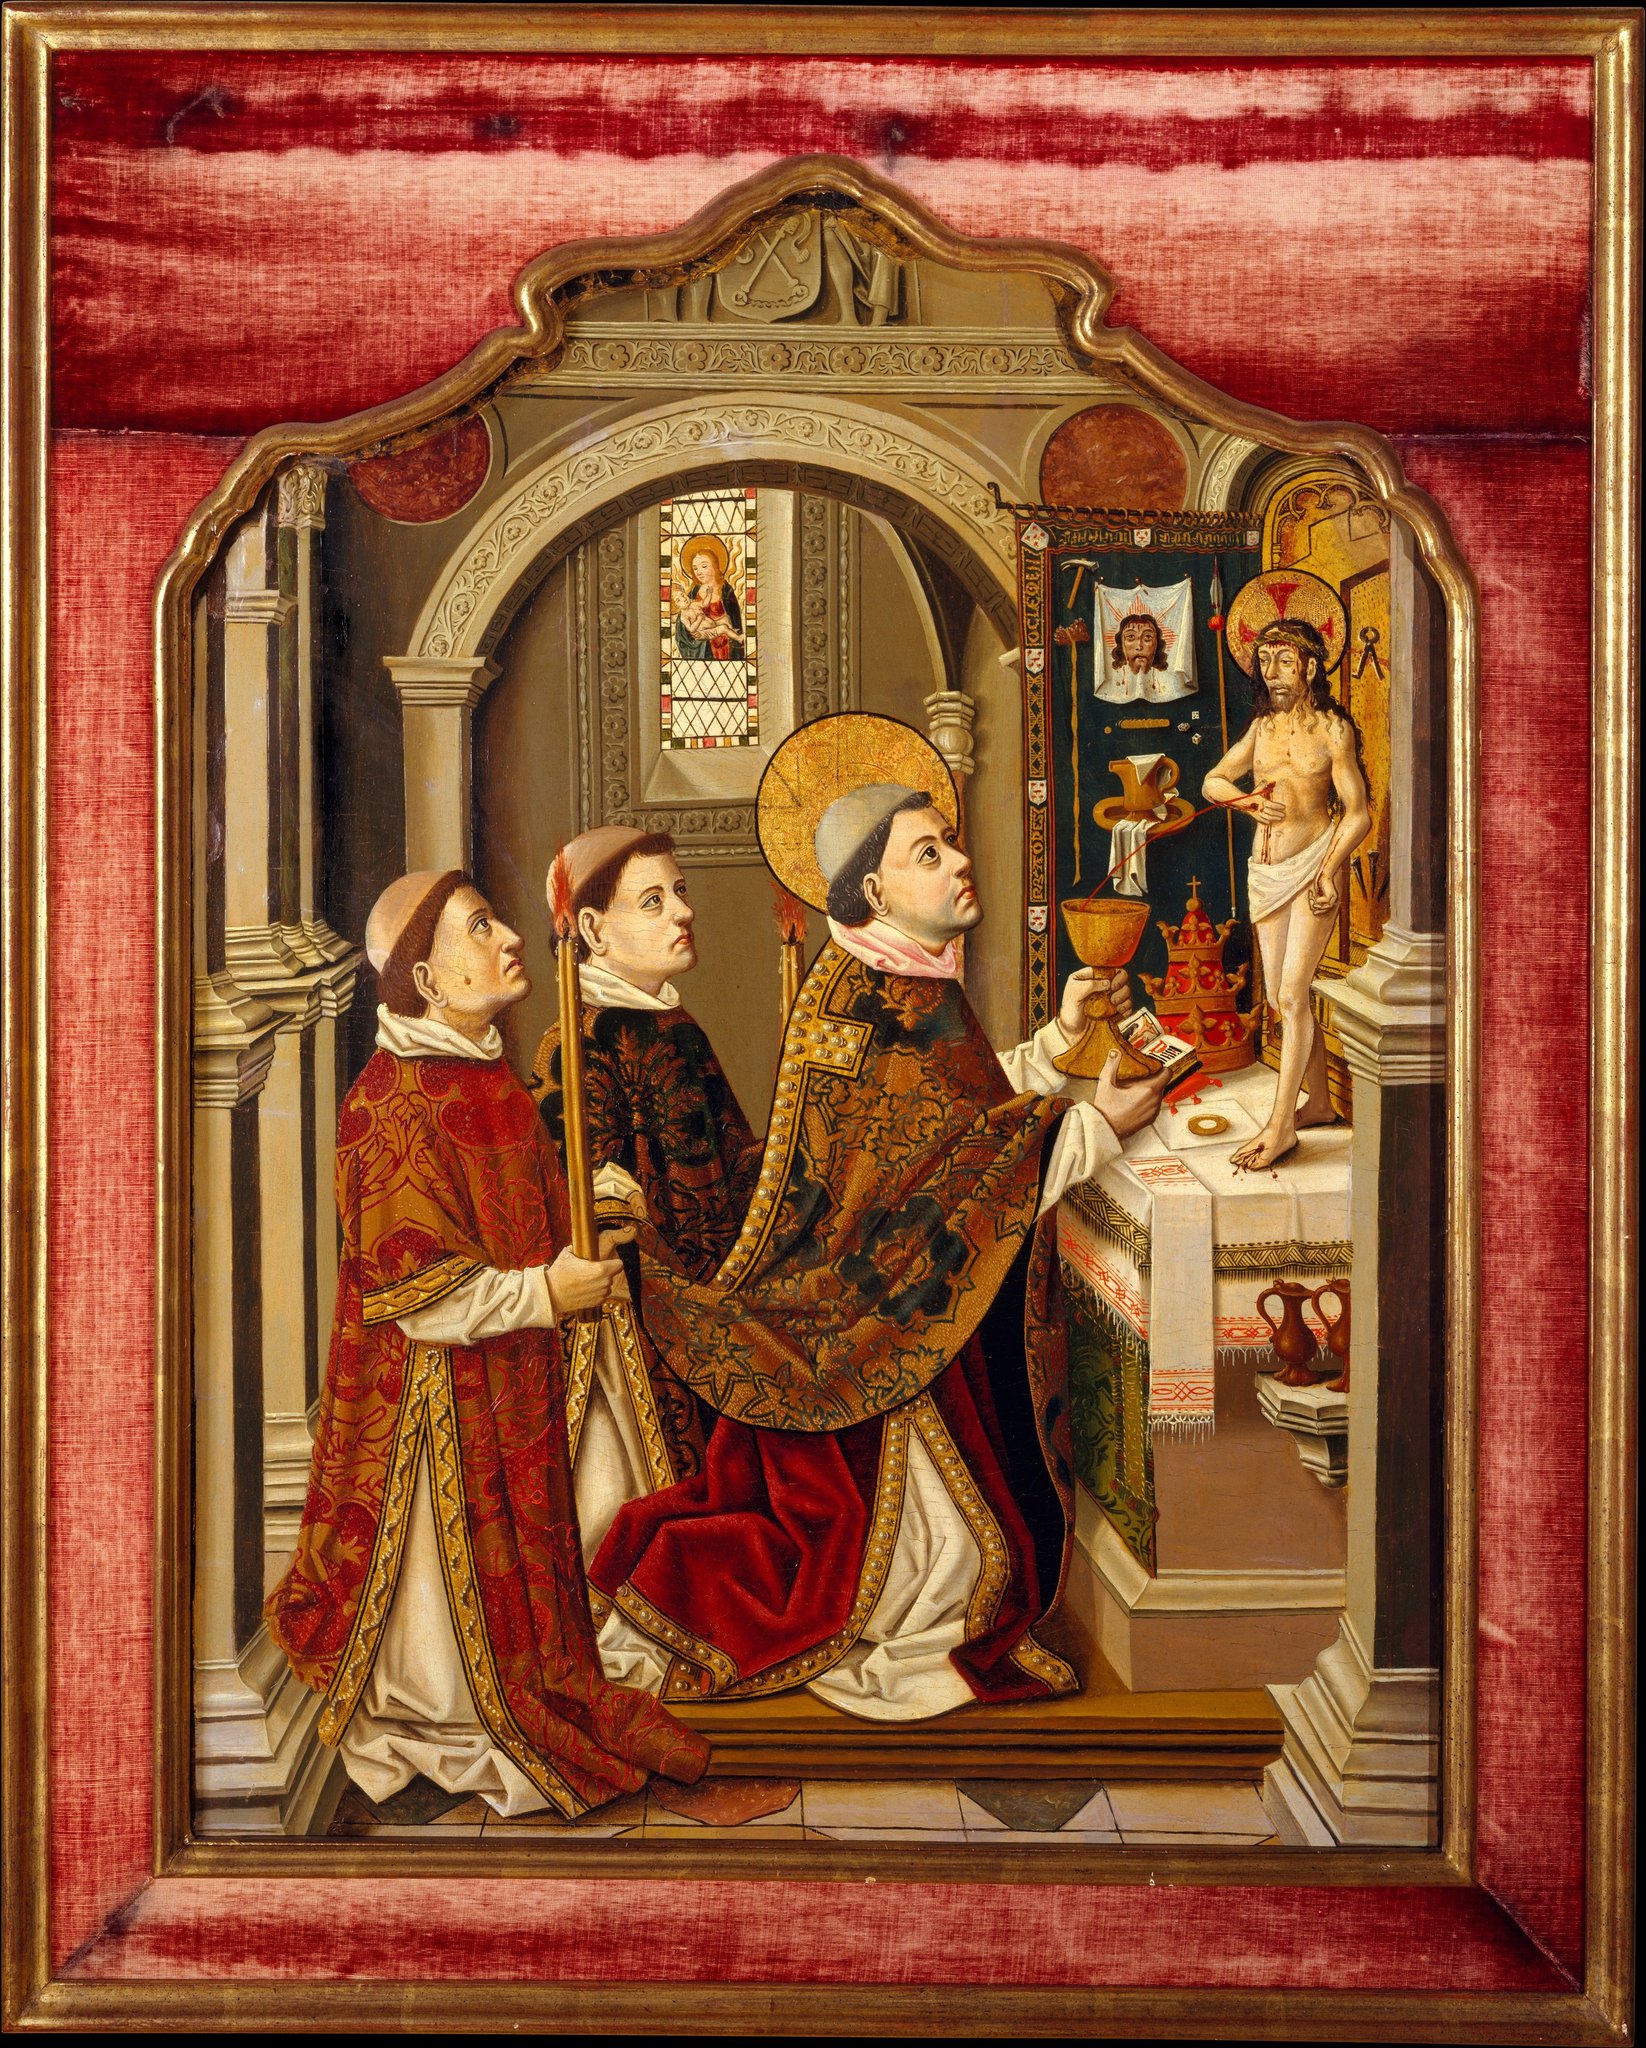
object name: painting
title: The Mass of Saint Gregory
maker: spanish painter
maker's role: artist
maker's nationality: spanish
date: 1485-1495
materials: gold, oil, wood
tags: altars,men,christ,saints